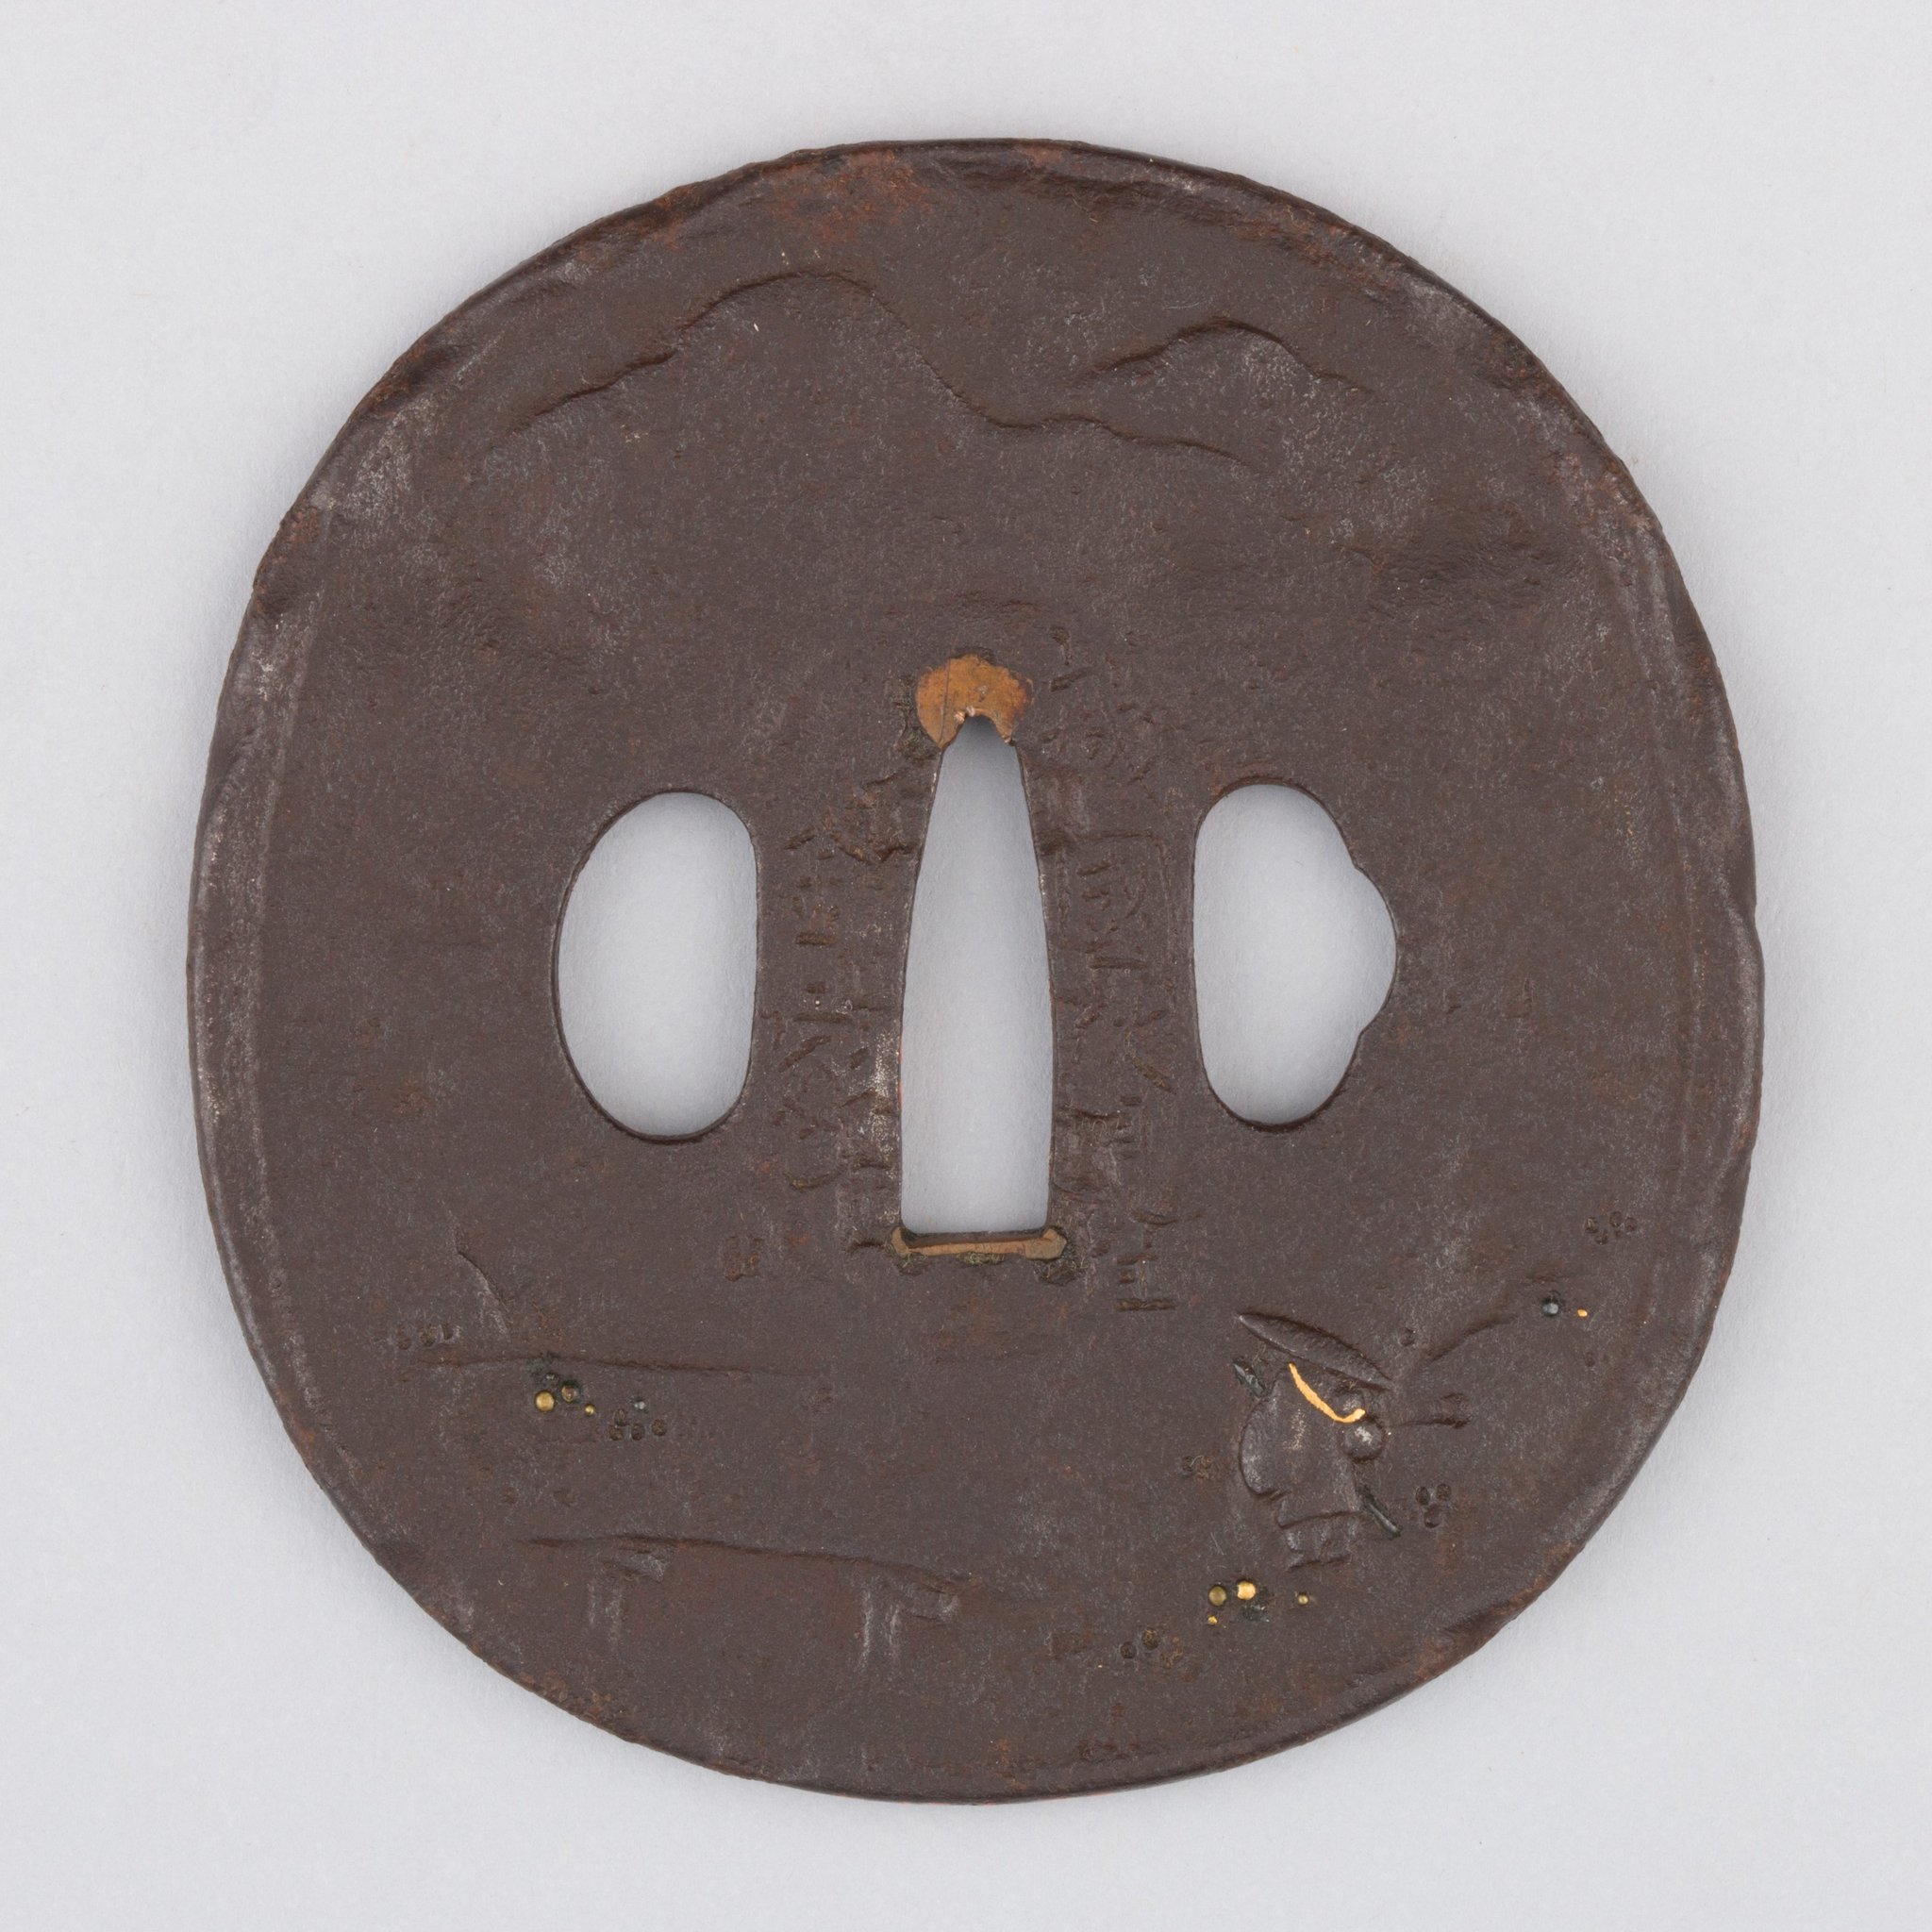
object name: sword guard tsuba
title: Sword Guard (Tsuba)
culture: japanese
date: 1615-1868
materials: copper, iron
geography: japan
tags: human figures